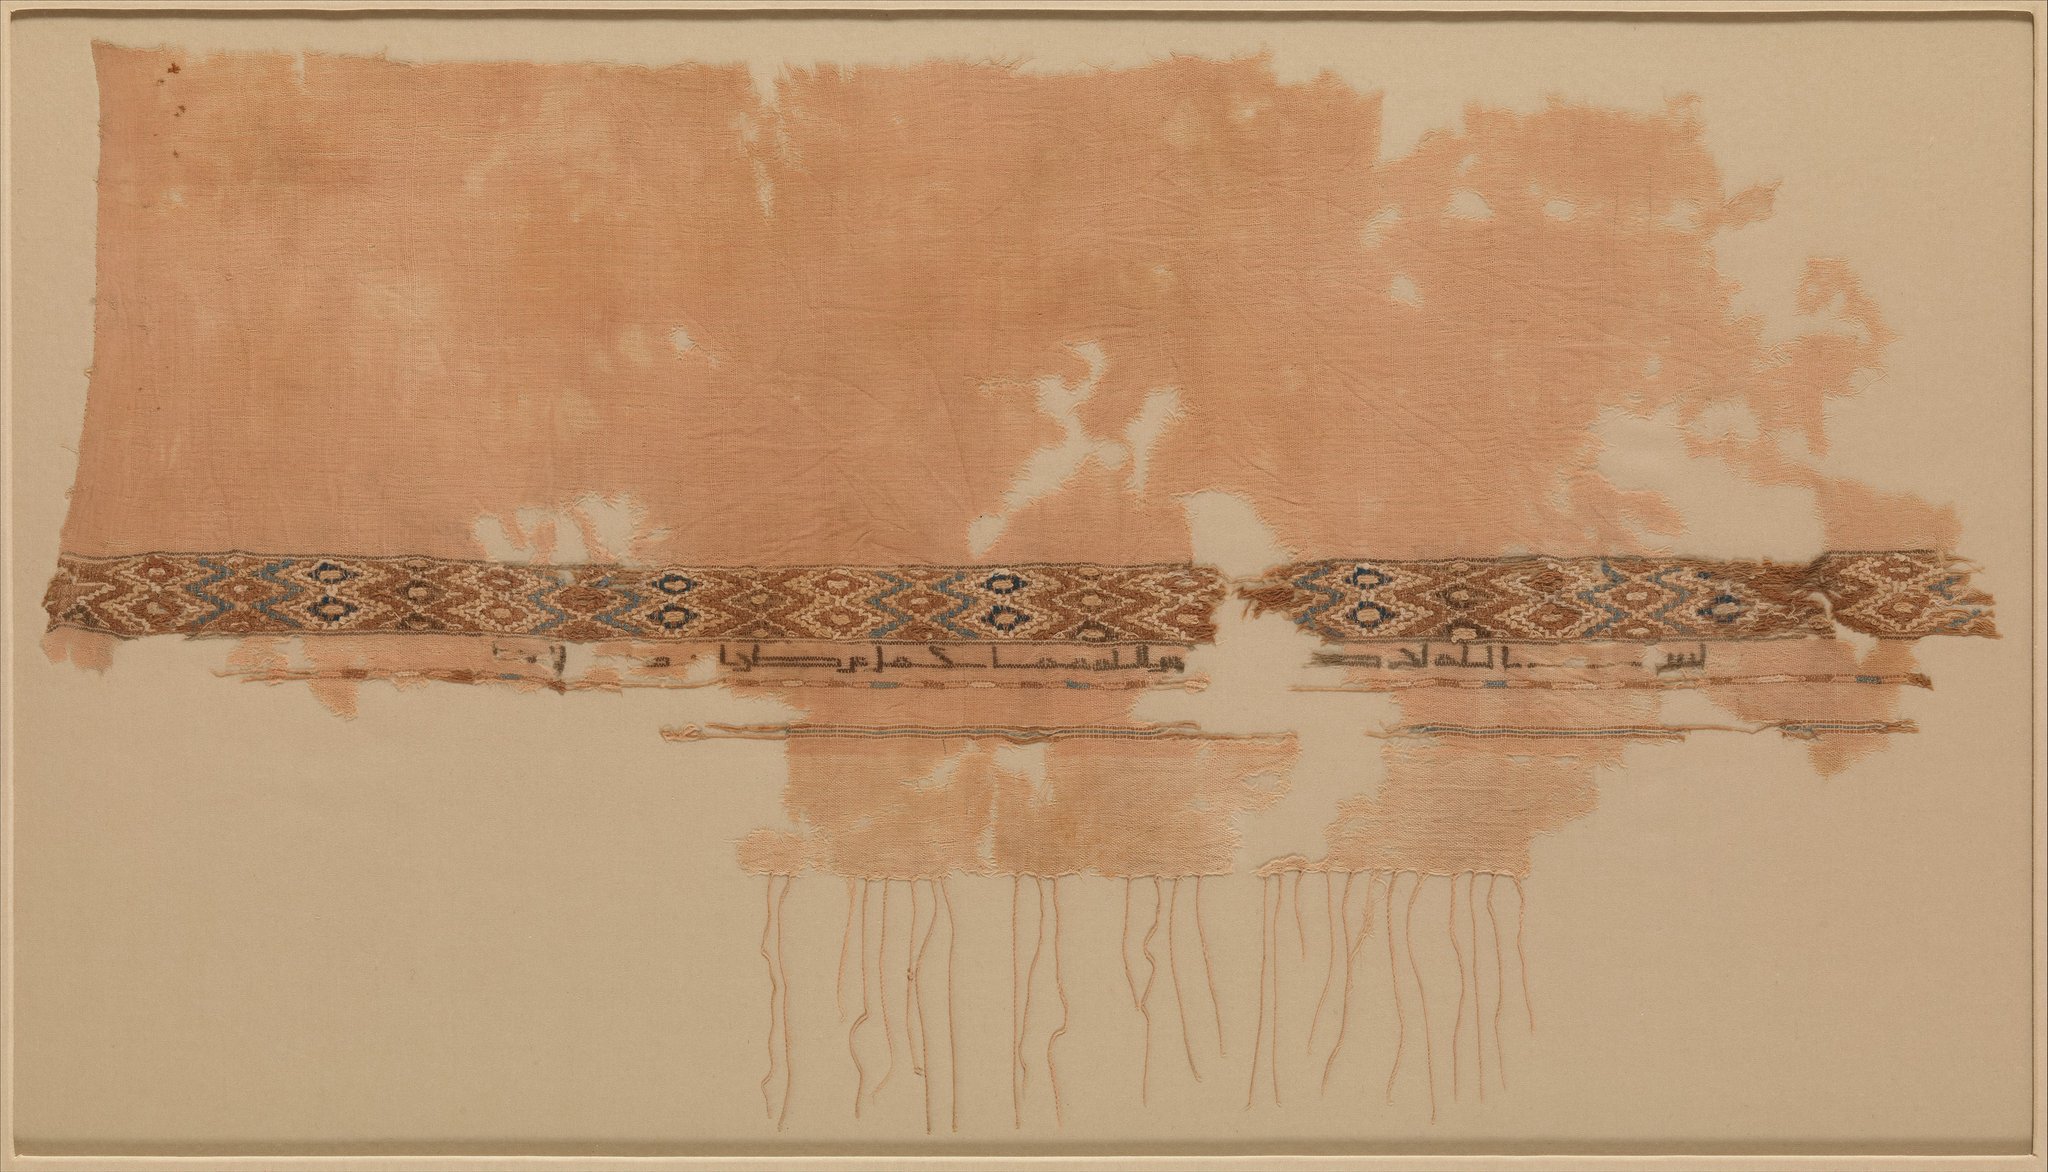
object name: textile fragment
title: Fragment of a shawl with inscription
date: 701-900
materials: cotton, wool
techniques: embroidery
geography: yemen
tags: arabic